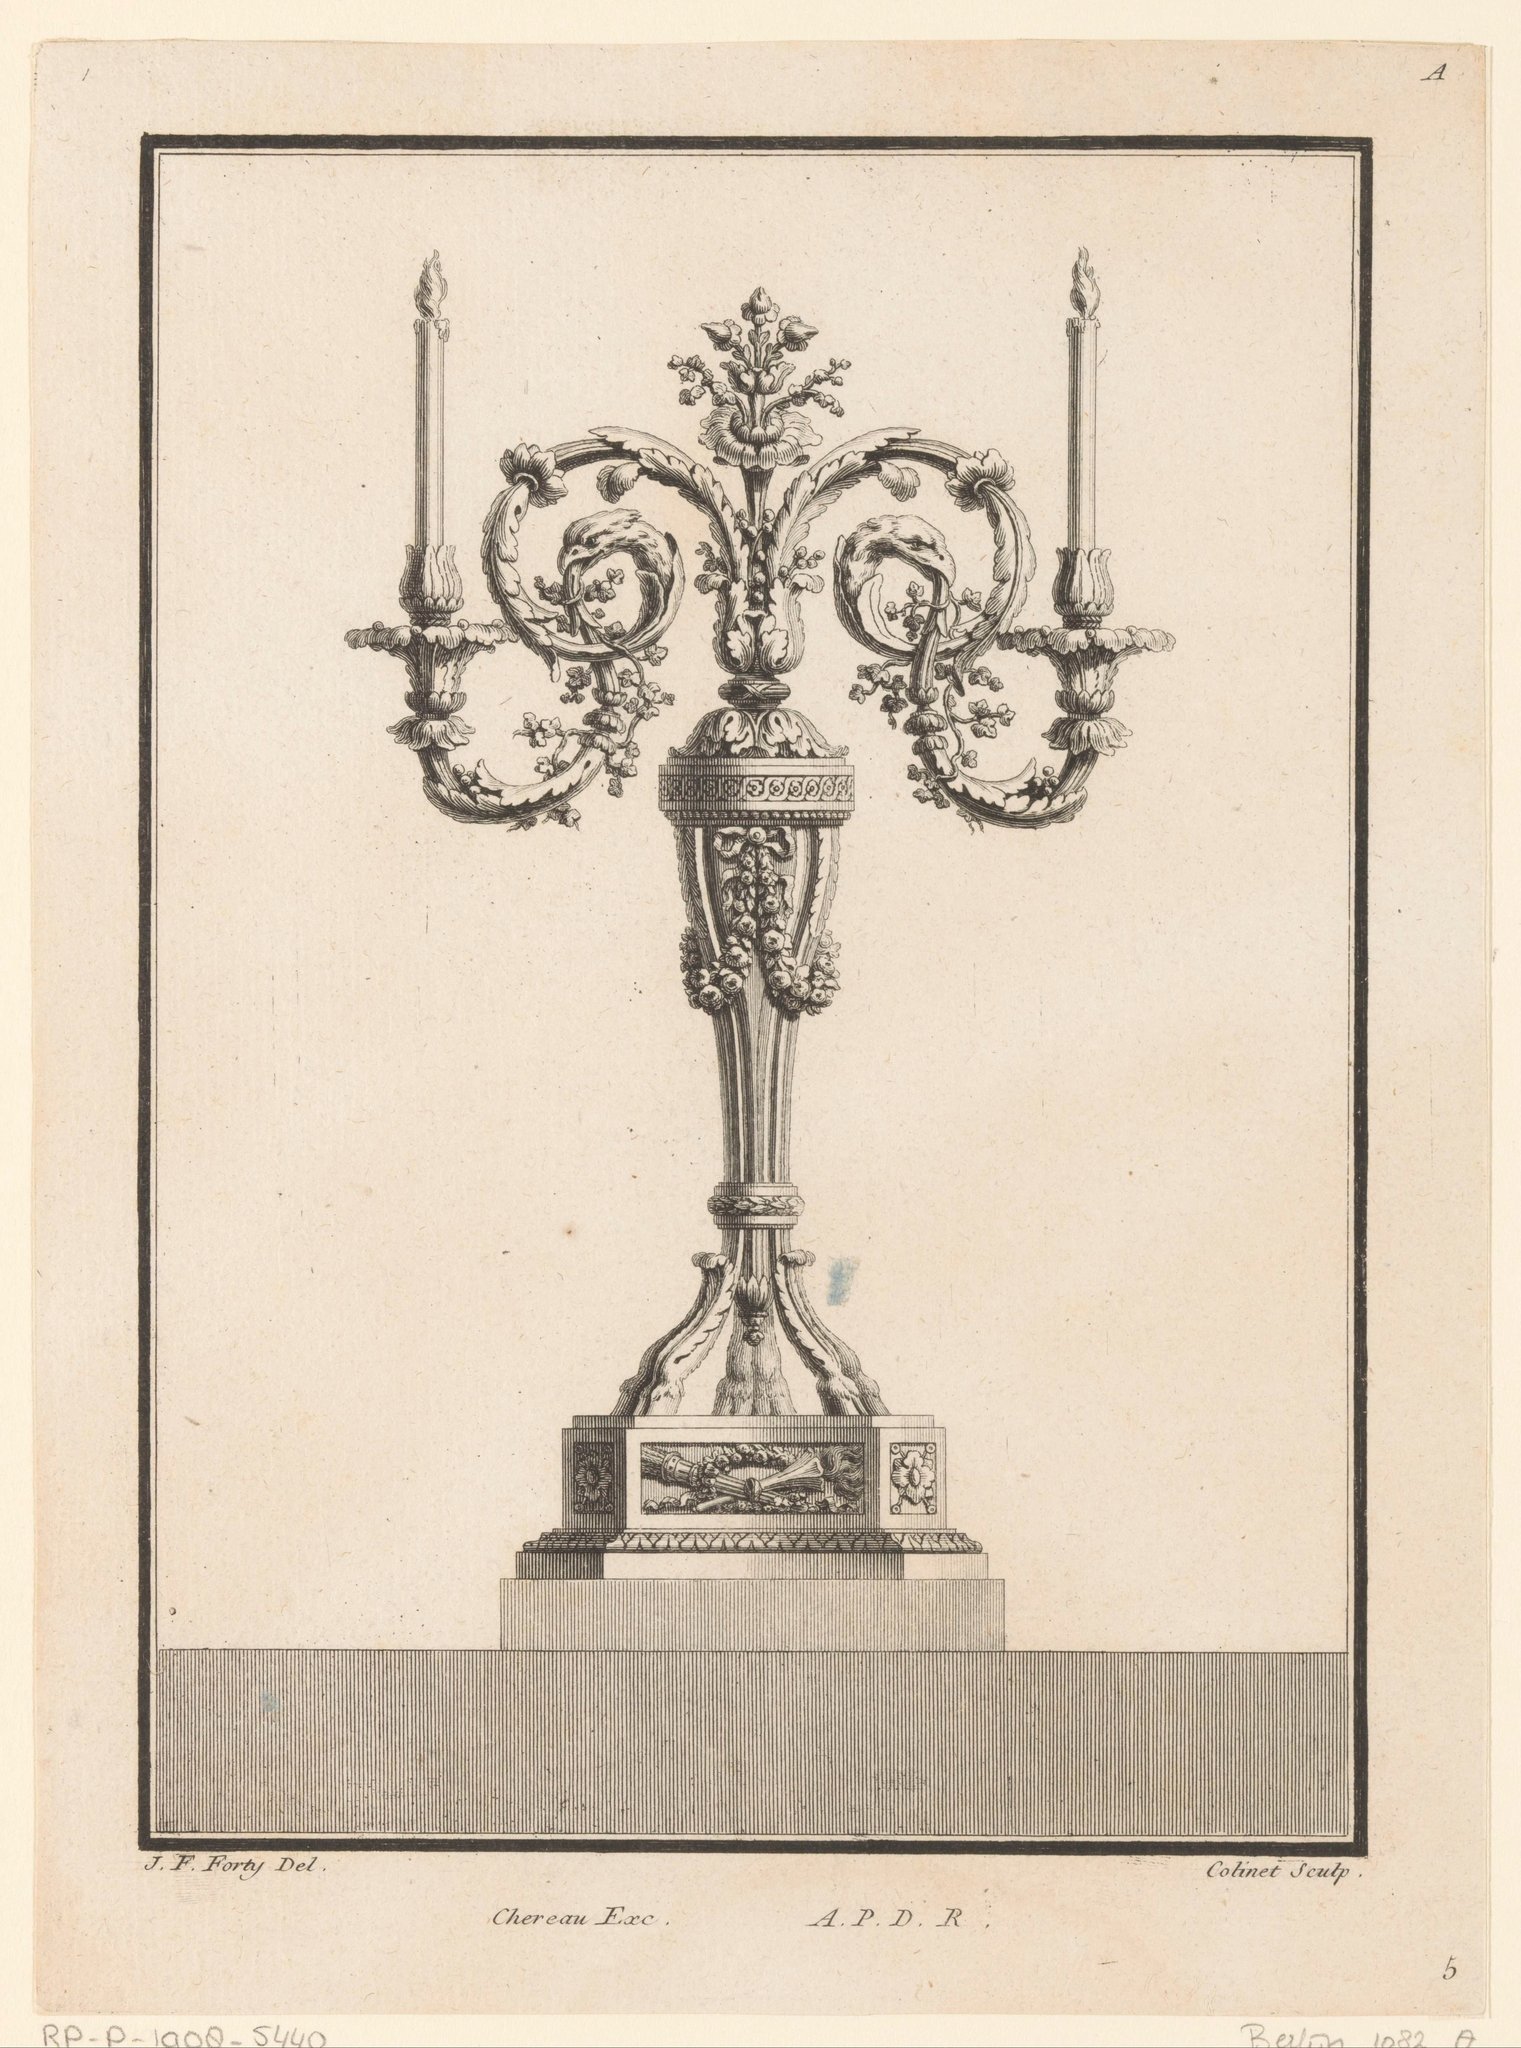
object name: print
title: Oeuvres de Sculptures en Bronze, Contenant Girandoles, Flambeaux, Feux (...)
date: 1775-1790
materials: paper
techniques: engraving, etching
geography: paris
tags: chandelier, candelabrum, birds (+ head of an animal)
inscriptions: collector's mark: Lugt 2228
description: Een geornamenteerde tweearmige girandole op bokkenpoten met ranken en vogelkoppen.